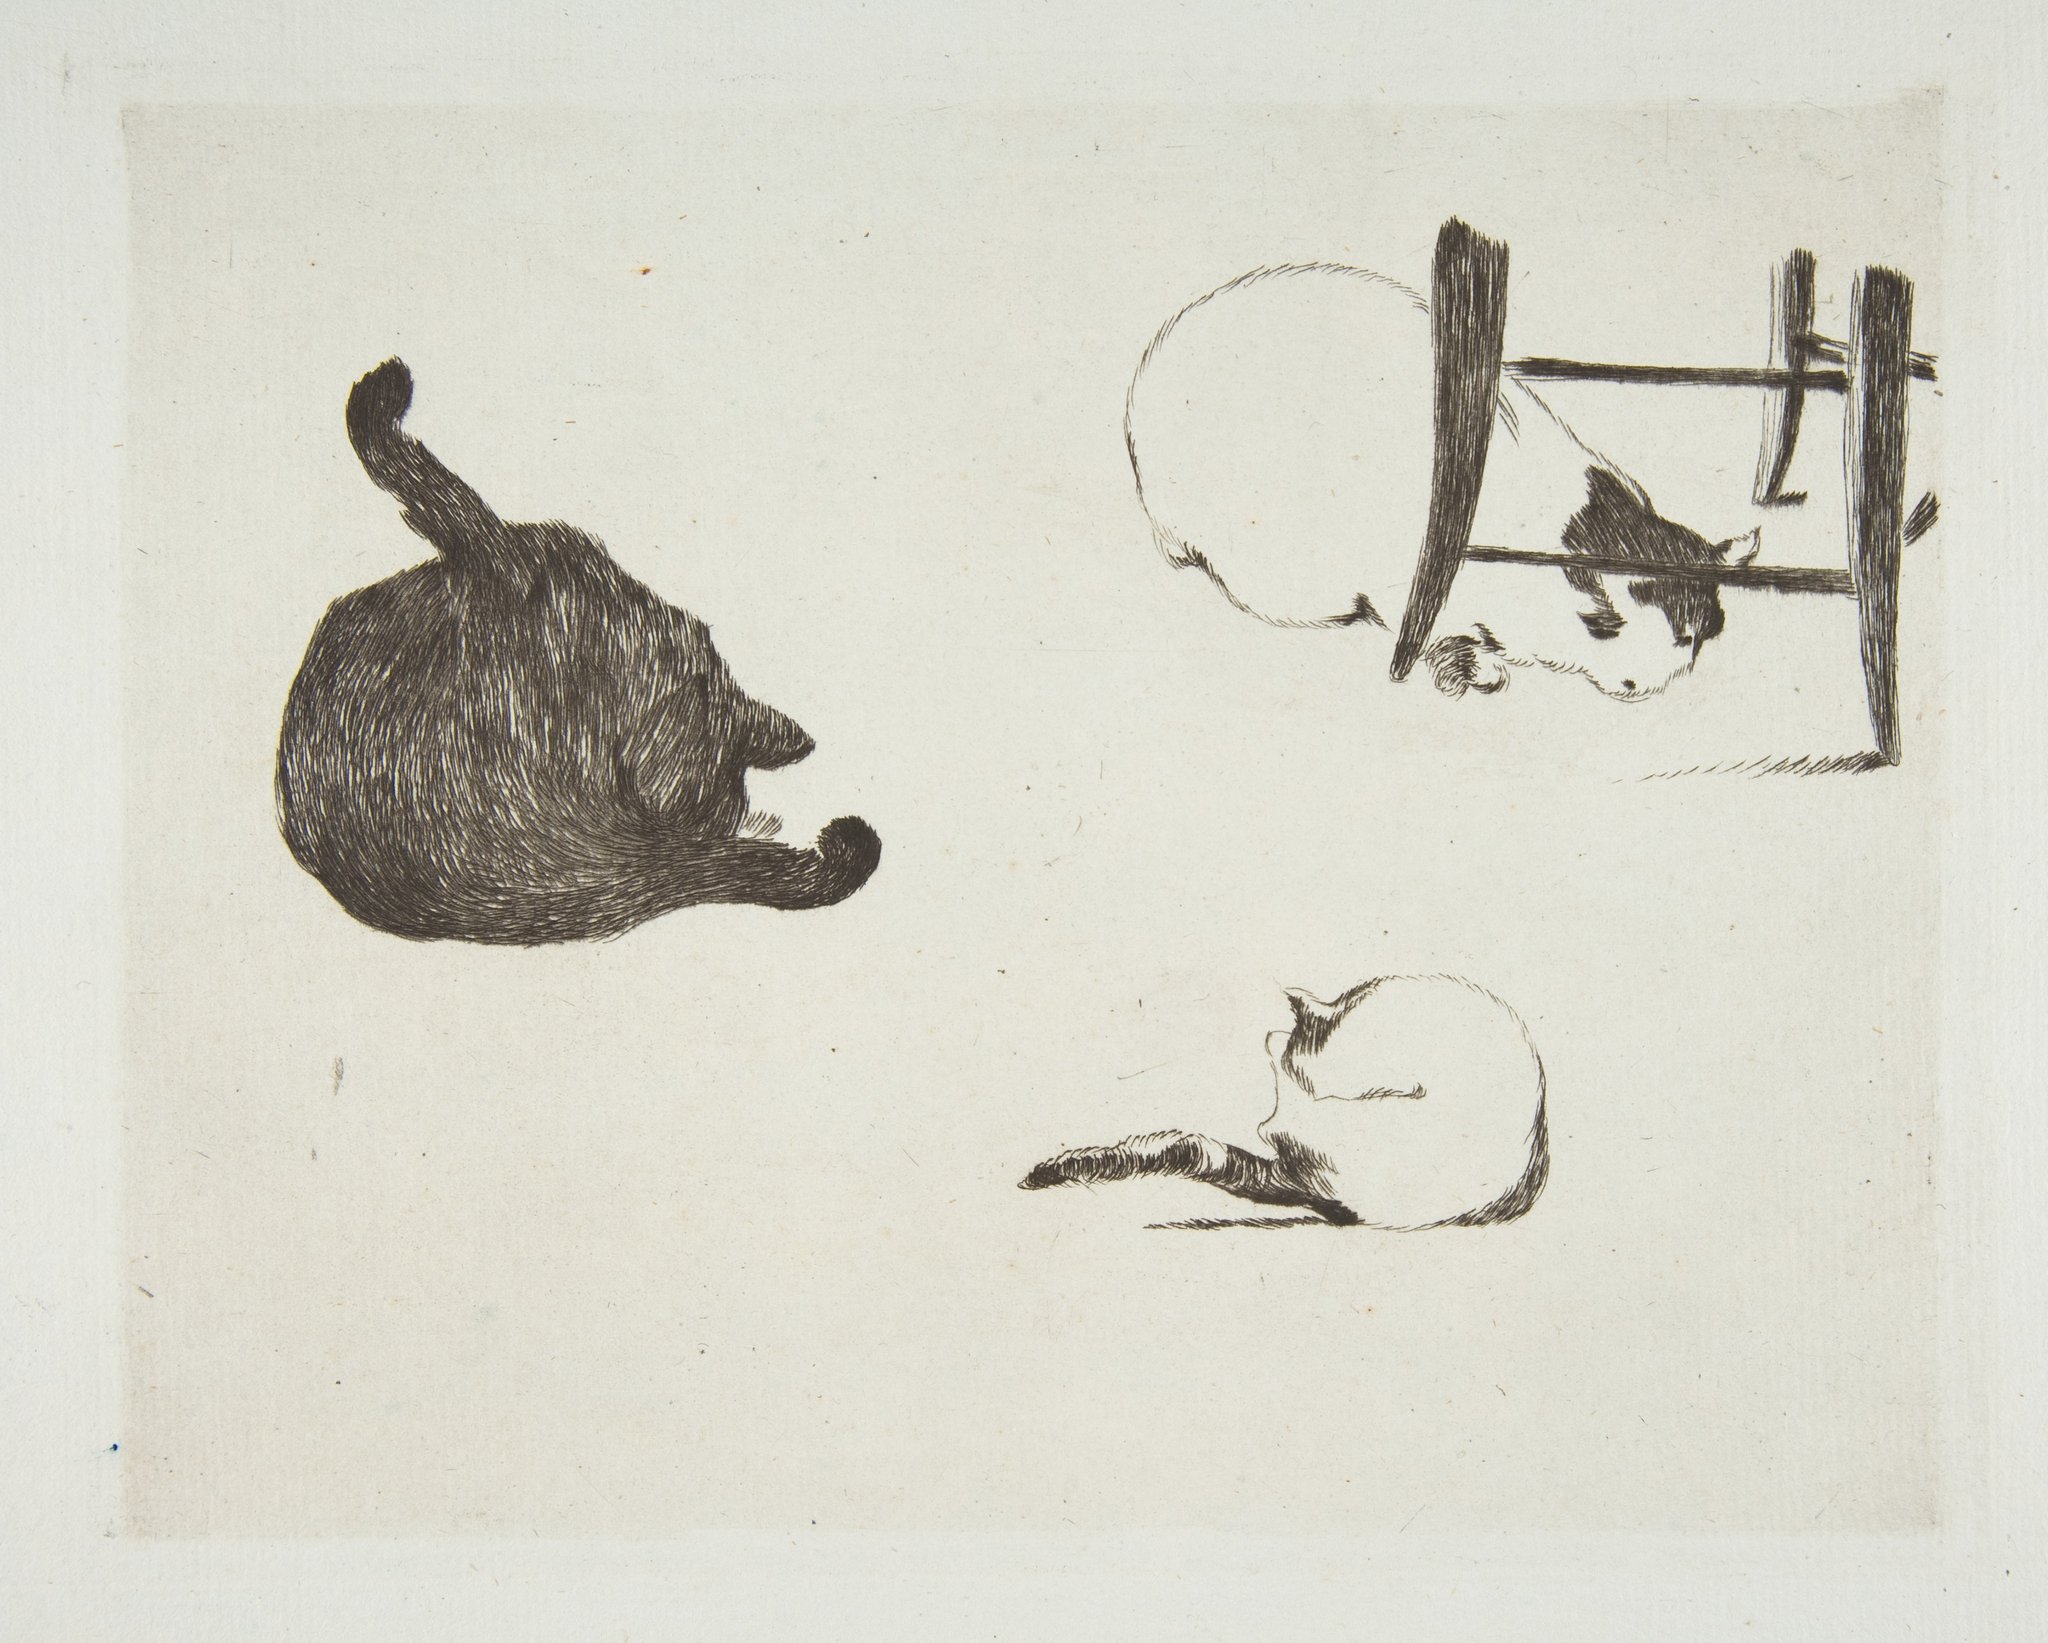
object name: print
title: Cats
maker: édouard manet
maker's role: artist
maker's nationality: french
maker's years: 1832-1883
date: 1868-1869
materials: paper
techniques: etching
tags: cats